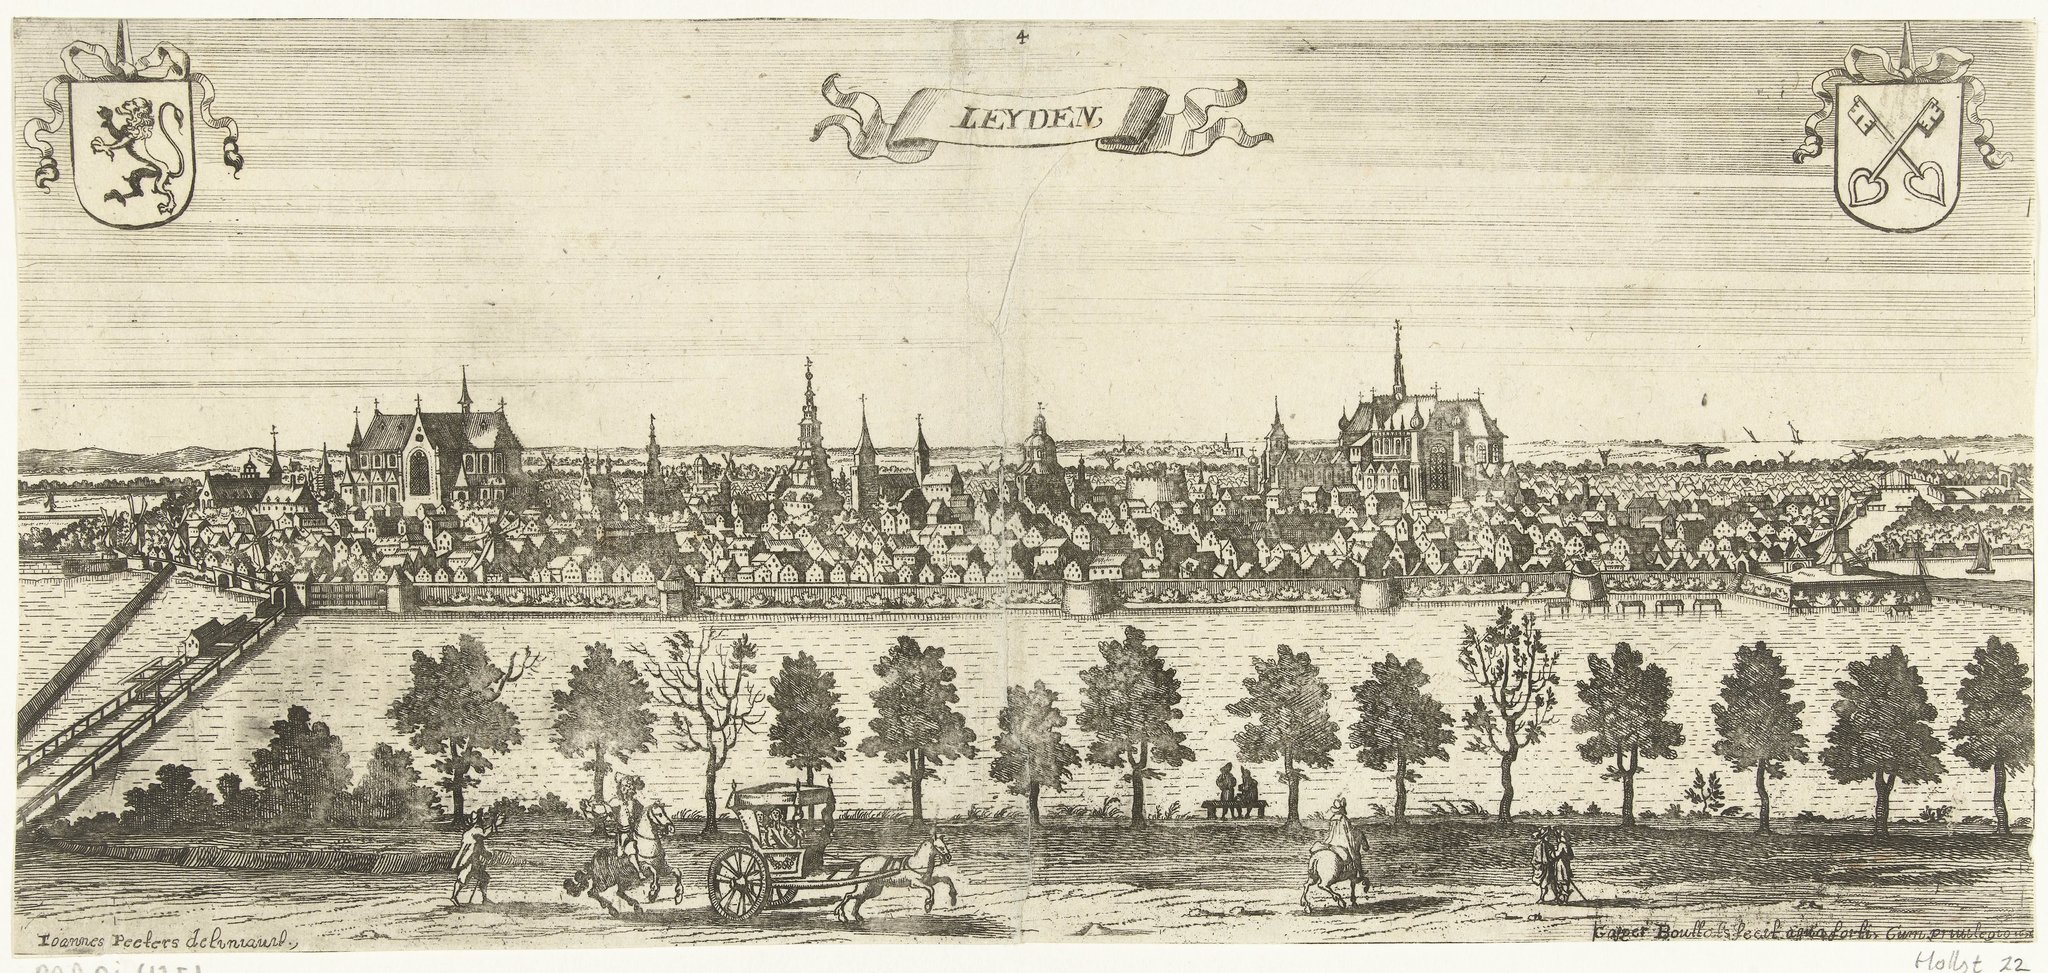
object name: print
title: Steden en vestigingen in de Republiek der Nederlanden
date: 1675-1679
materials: paper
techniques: etching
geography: antwerp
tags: prospect of city, town panorama, silhouette of city, leiden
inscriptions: collector's mark: Lugt 240 of 1838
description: Gezicht op de stad Leiden. Op de voorgrond, buiten de stadsmuren, de rivier De Rijn en enkele wandelaars, ruiters en een koets. Boven het stadsgezicht een cartouche met de naam van de stad en twee wapenschilden.